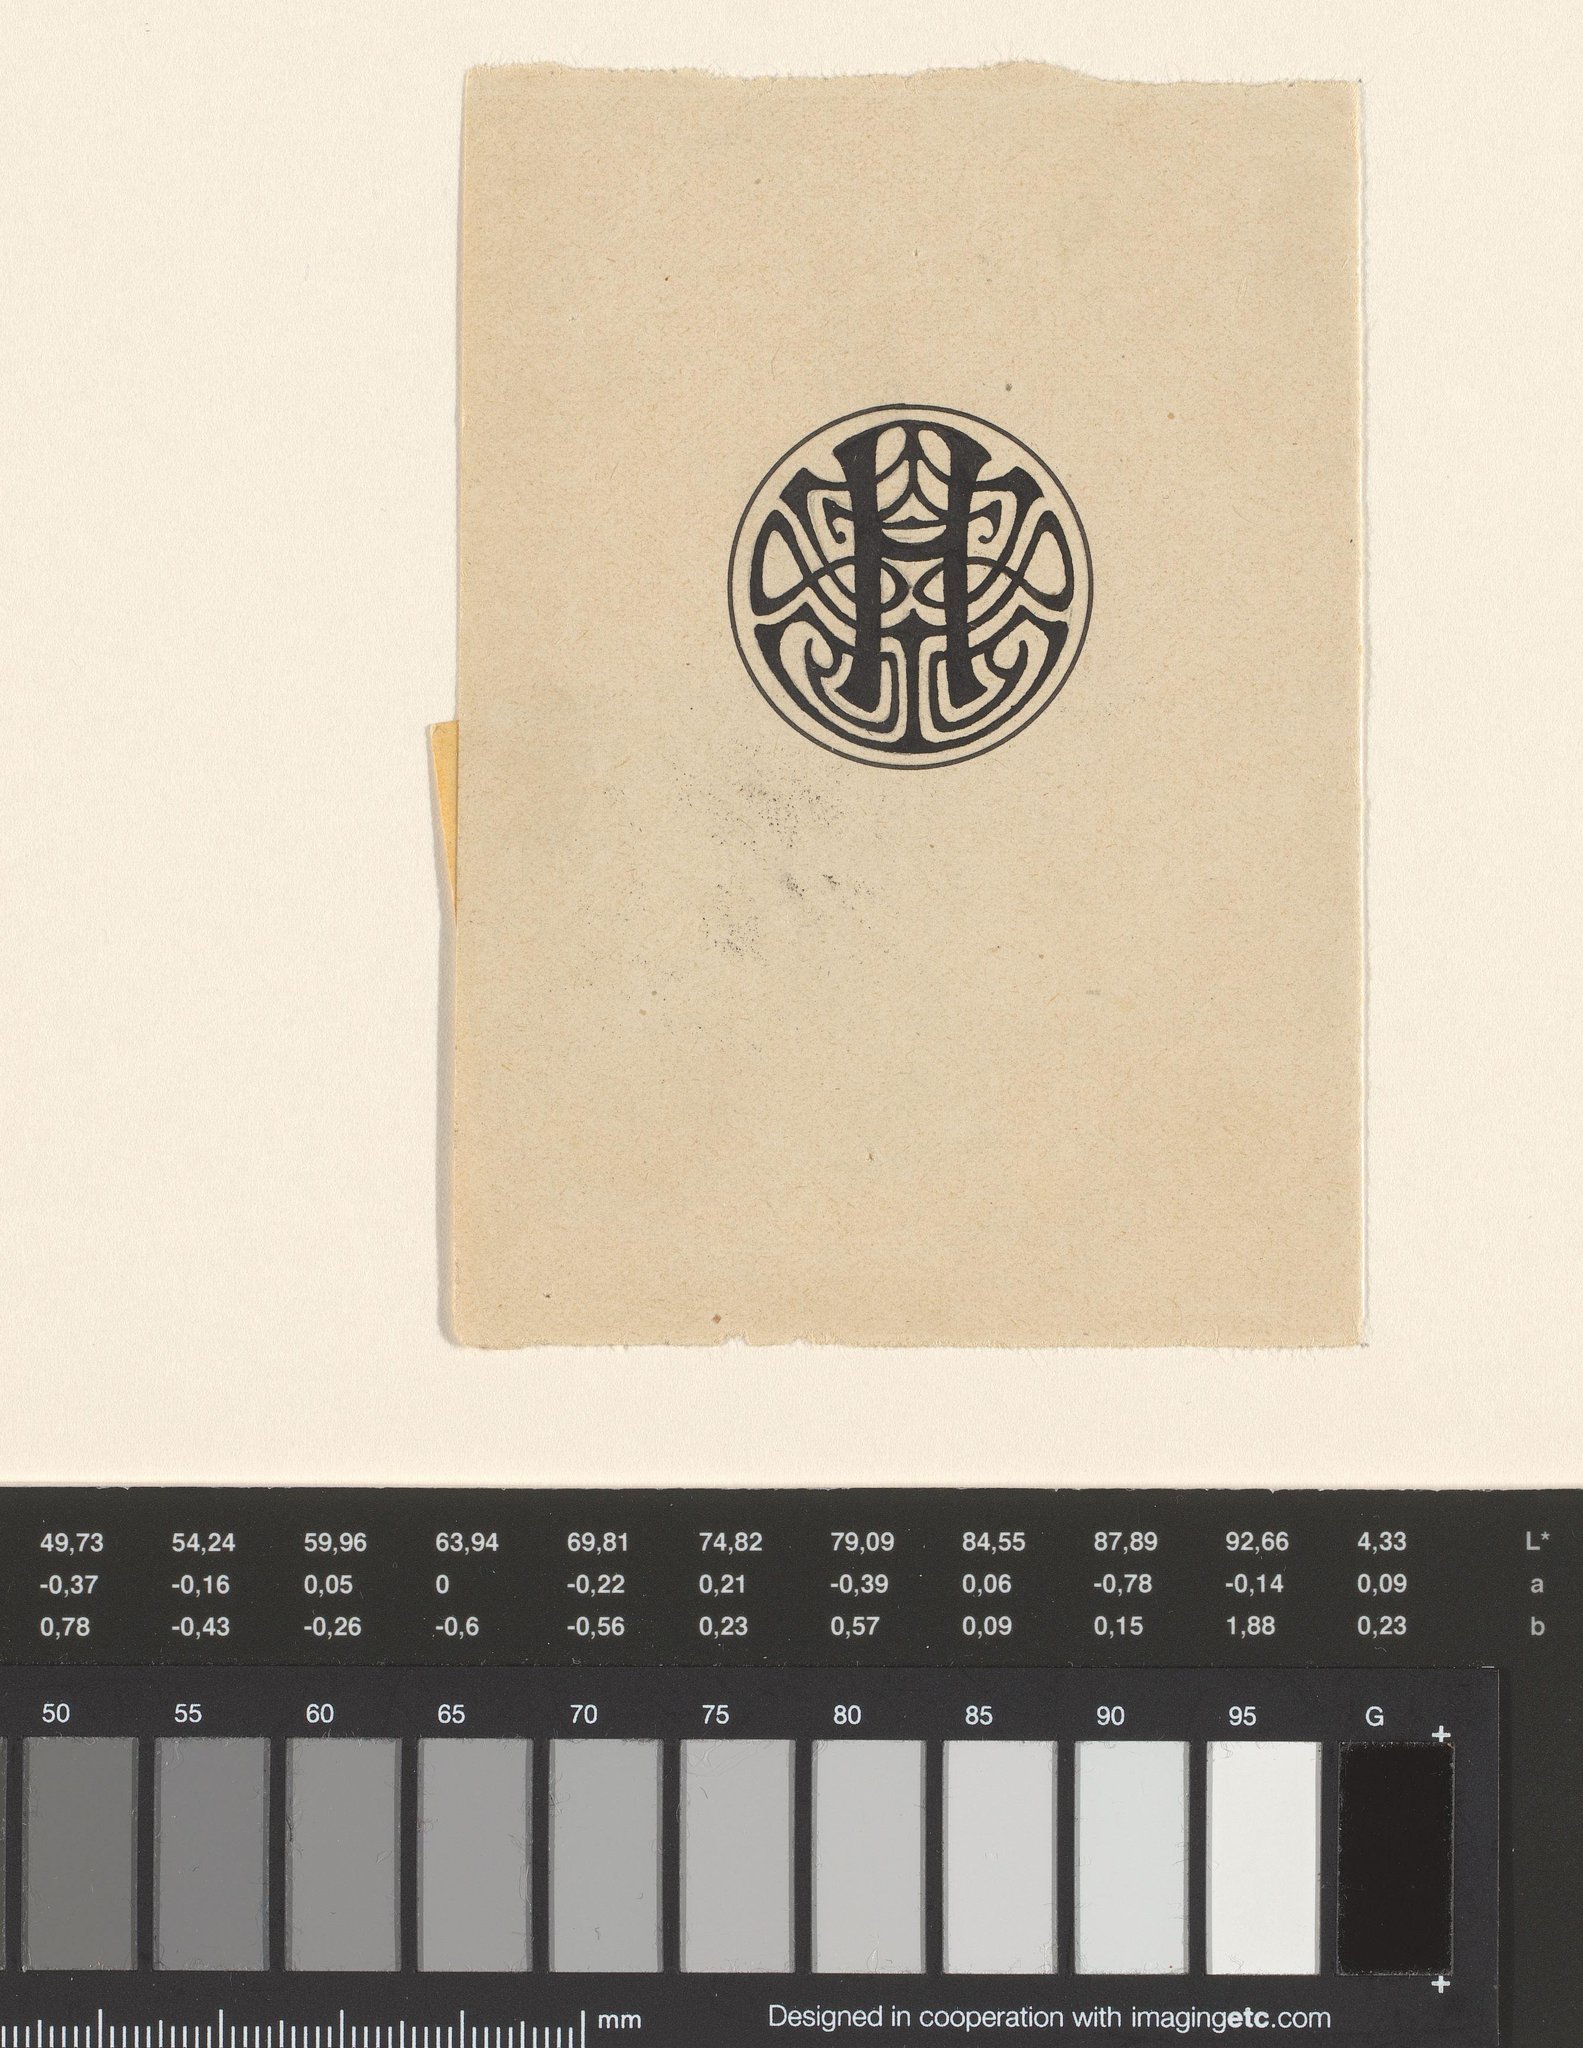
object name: drawing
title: Ontwerp voor een ex libris met de letter H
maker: julie de graag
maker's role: draughtsman, print maker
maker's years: 1877-1924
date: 1887-1924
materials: ink, paper, pencil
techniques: pen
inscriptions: number: ‘130 M’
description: Rond ex libris met de letter H en vervlochten lijnen.